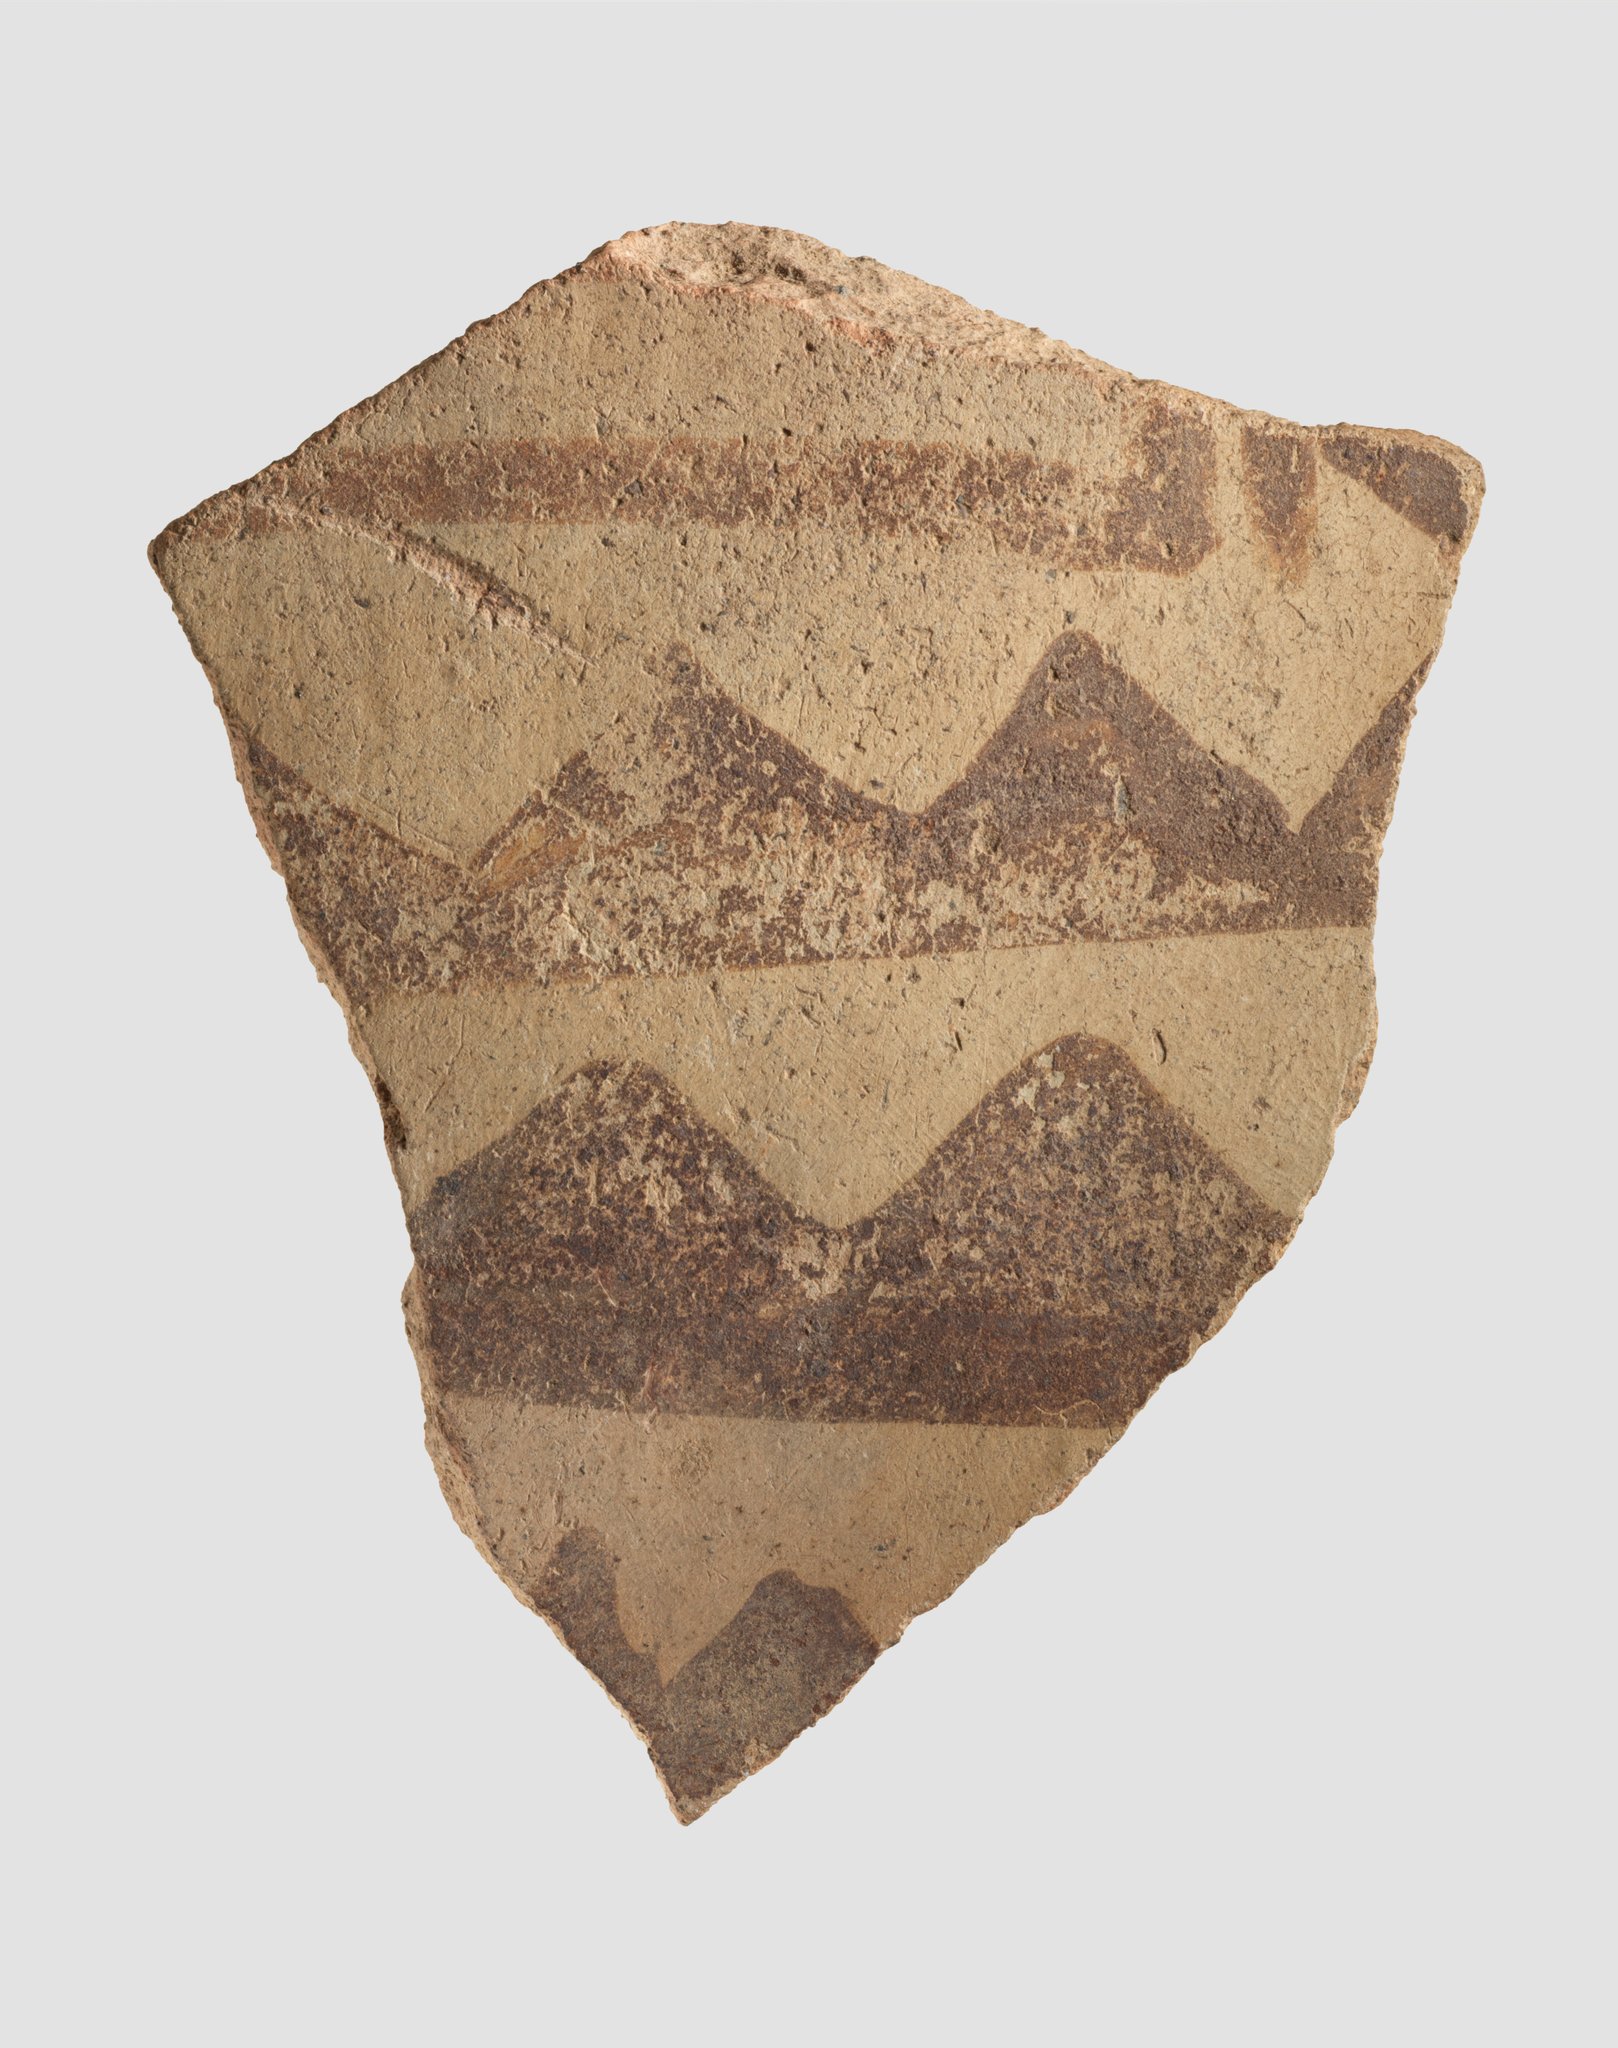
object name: sherd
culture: iranian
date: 1500-1000 BCE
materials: ceramic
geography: iran